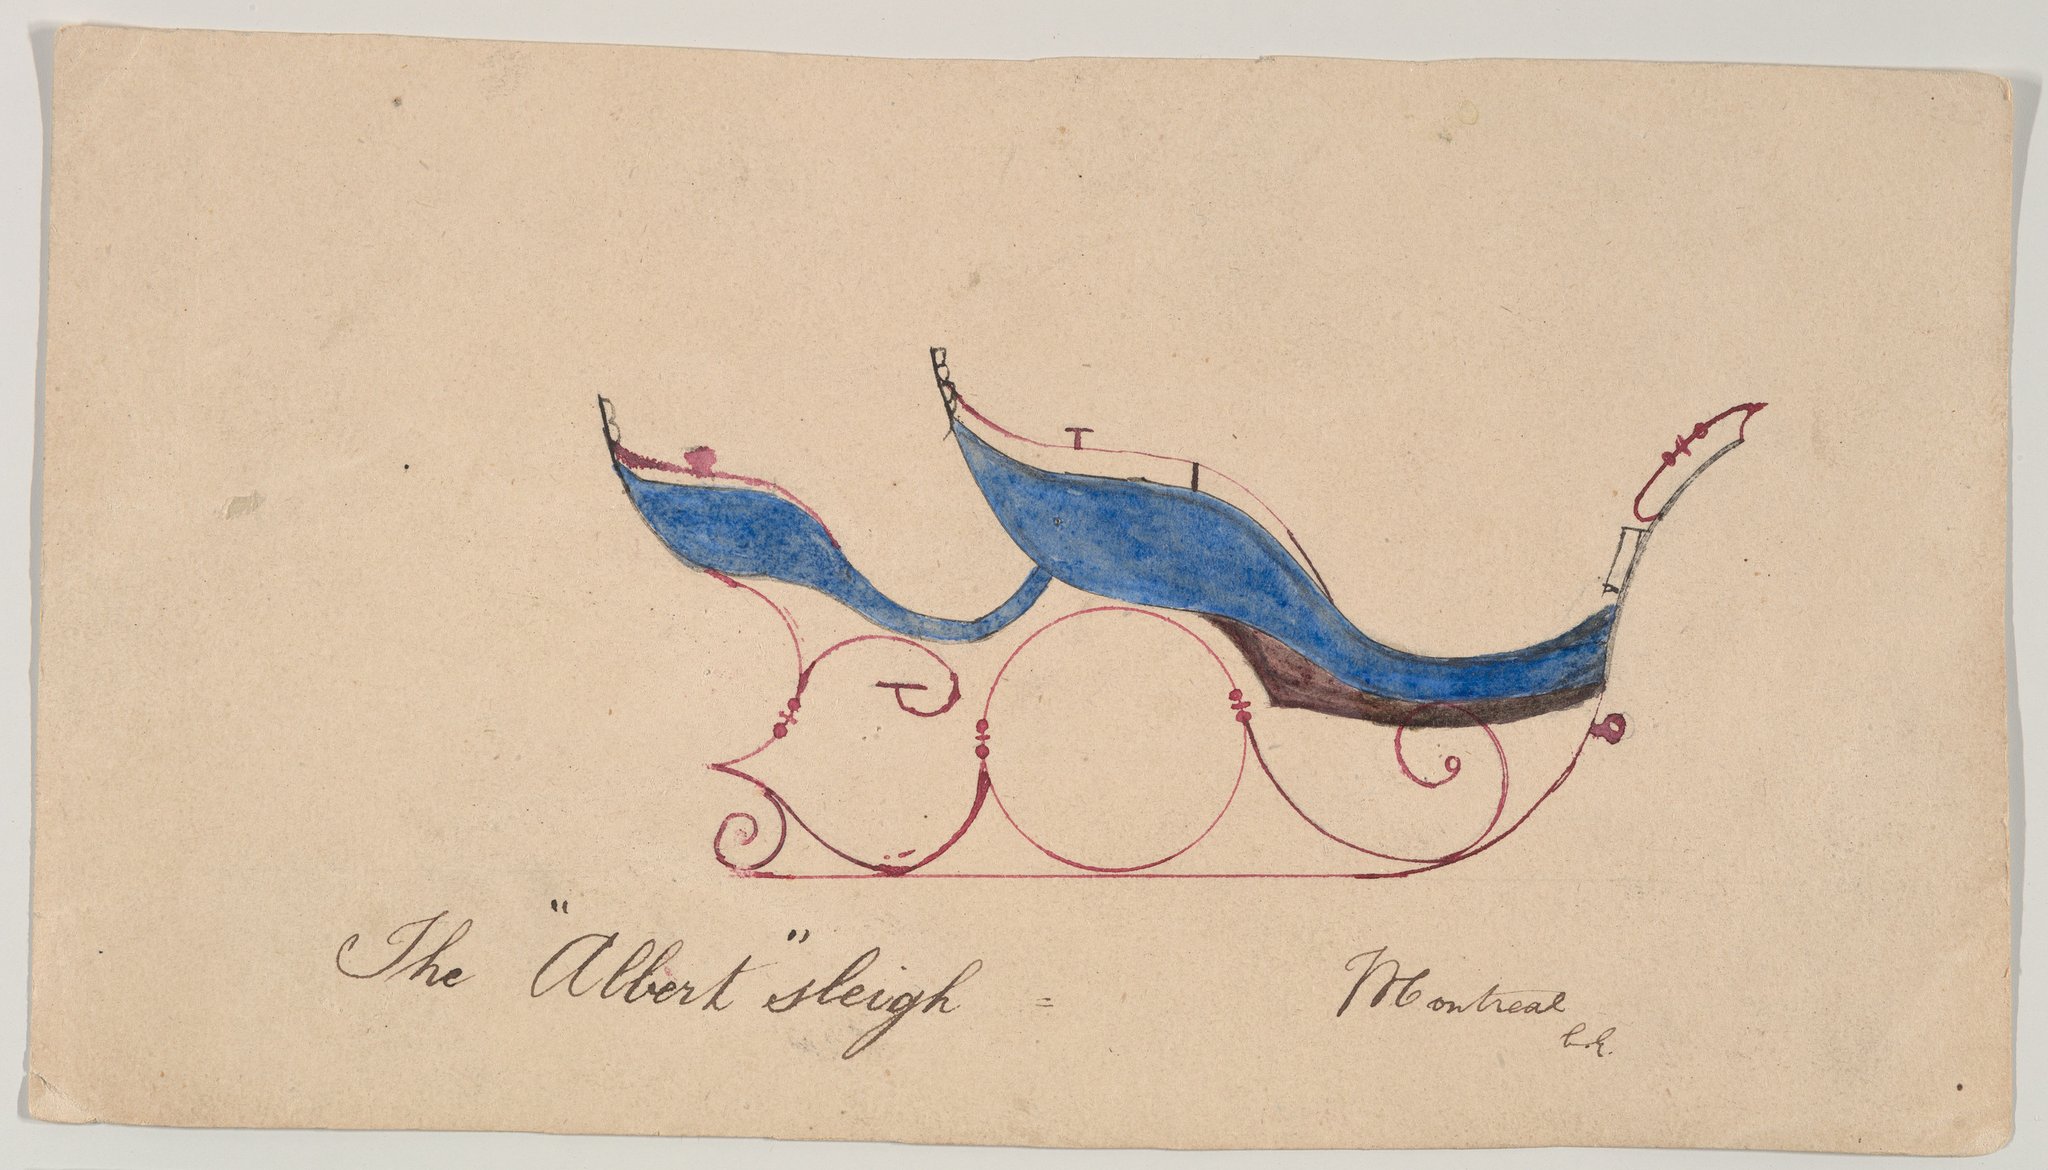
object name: drawing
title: Sleigh (unnumbered)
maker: brewster & co.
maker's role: manufacturer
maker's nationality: american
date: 1860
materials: gouache, graphite, ink, watercolor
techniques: pen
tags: carriages